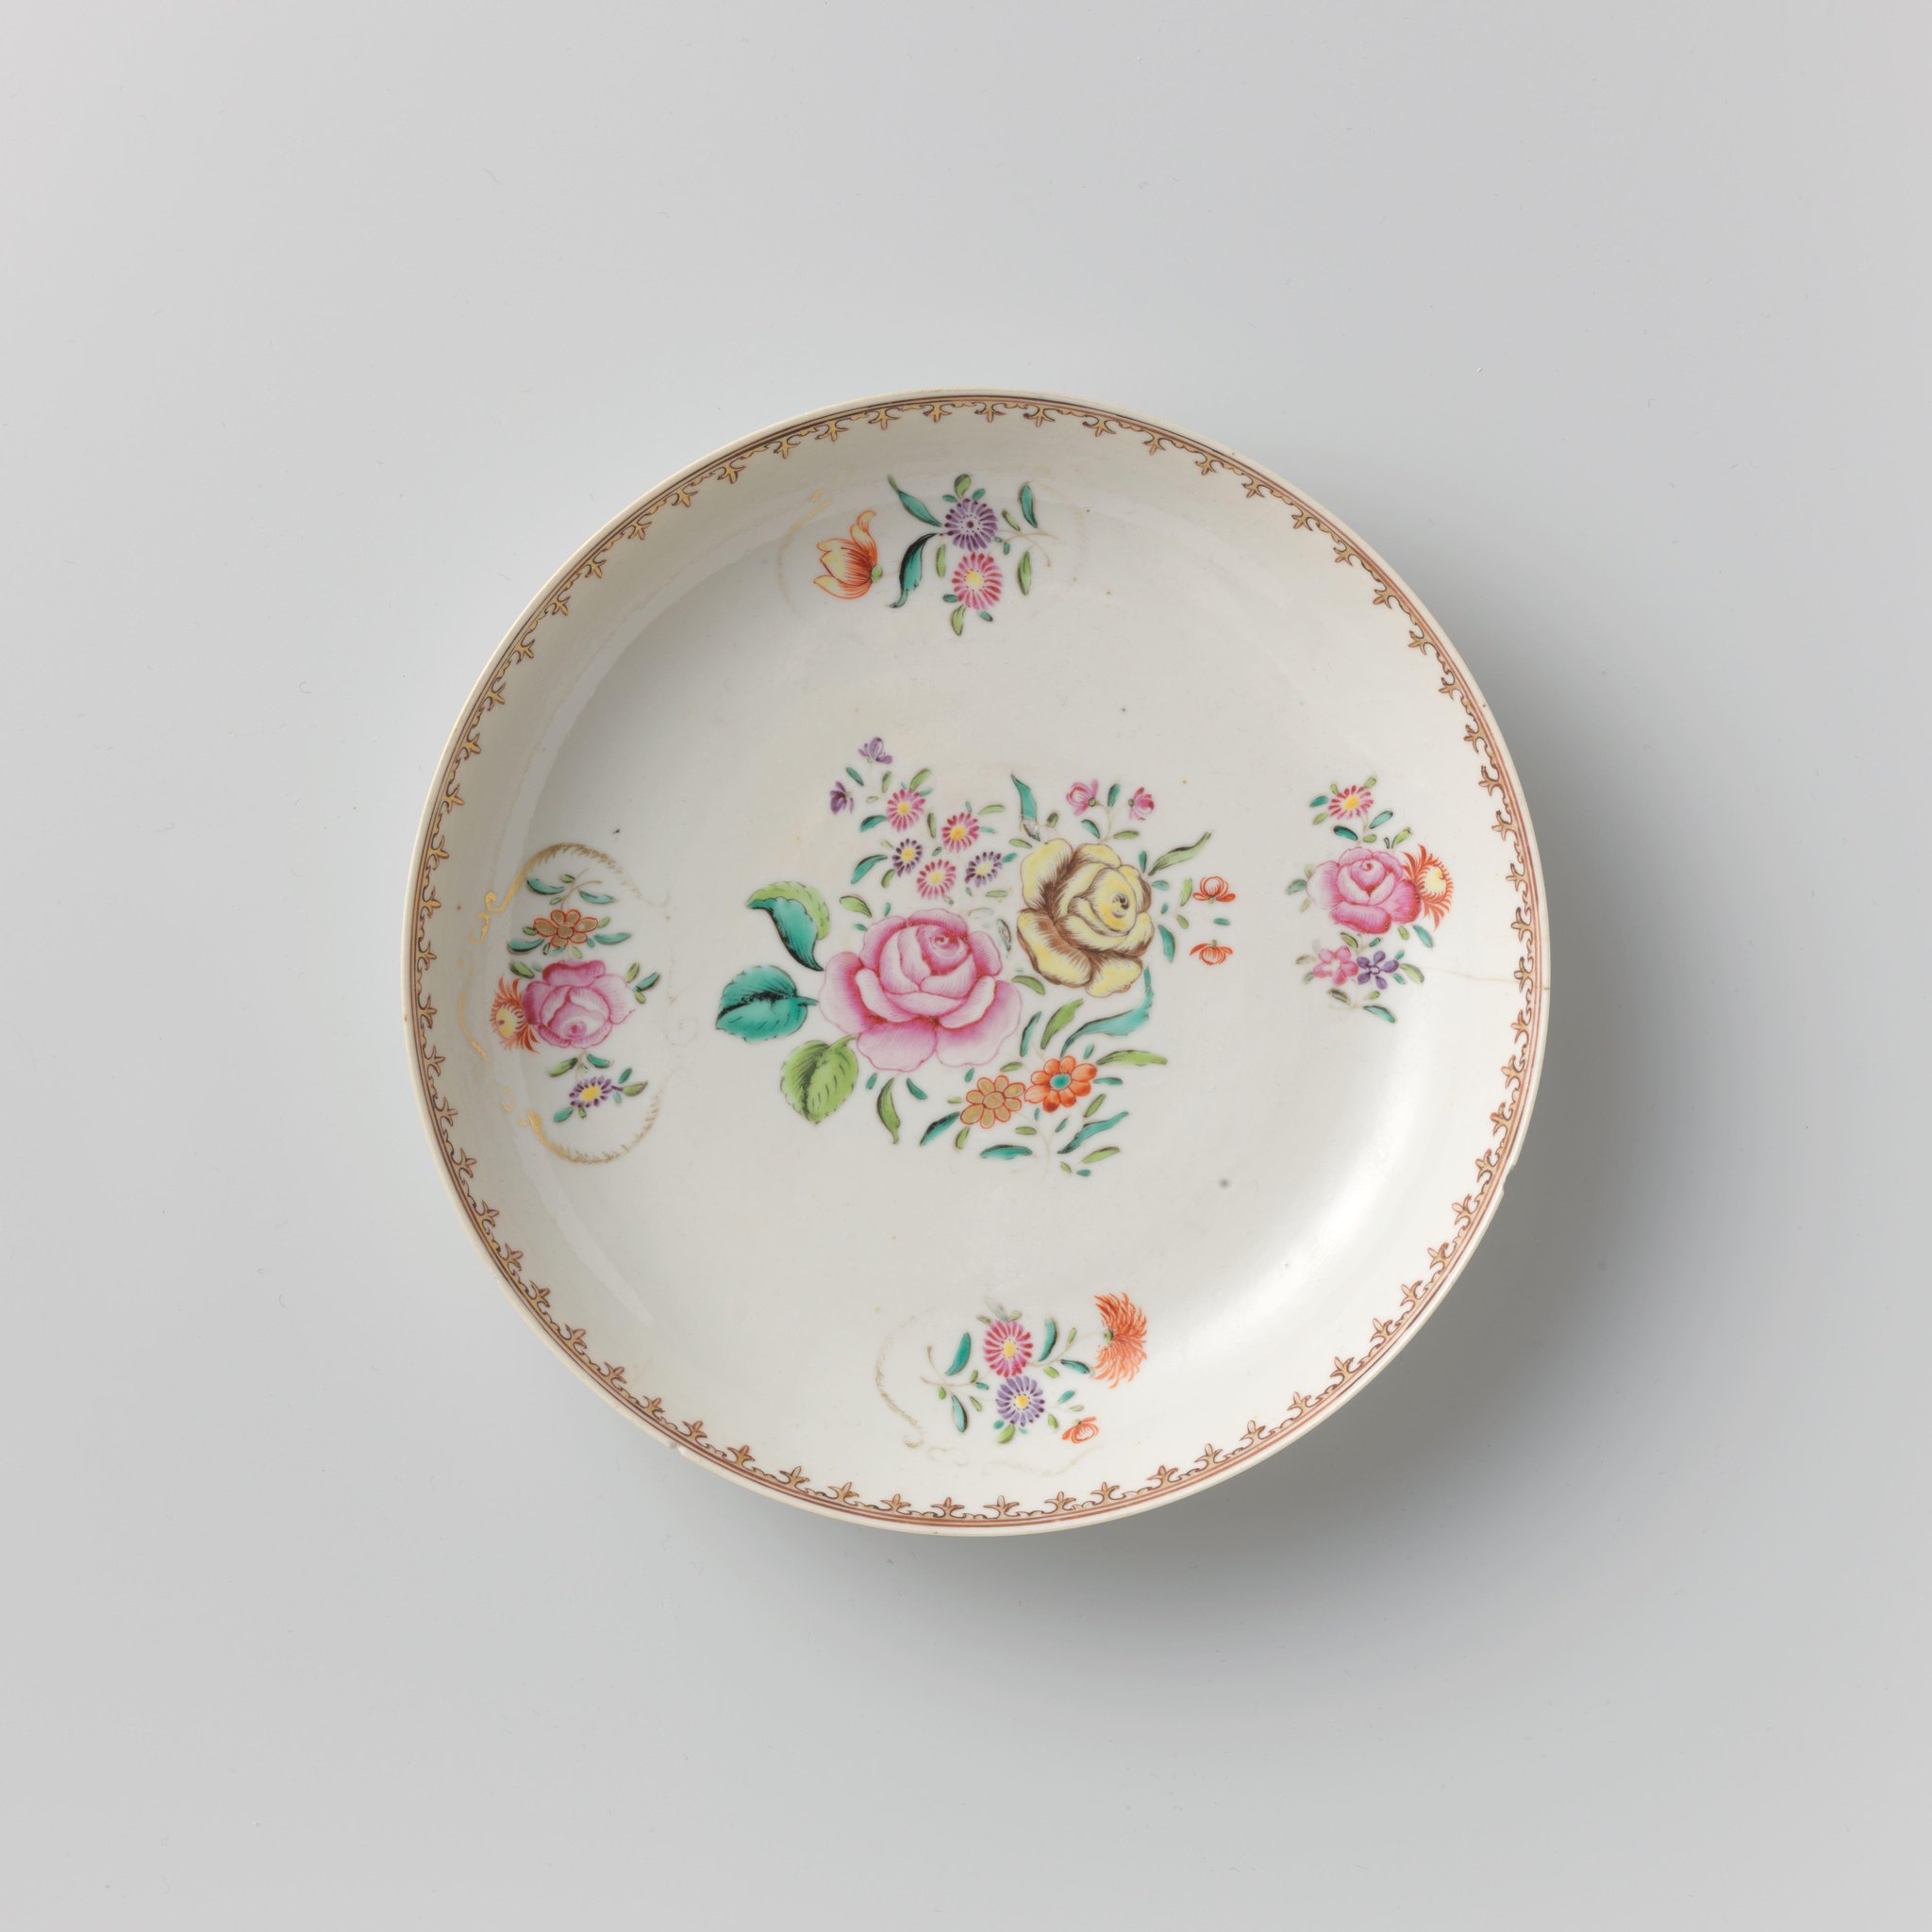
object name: dish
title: Saucer-dish with a group of flowers and flower sprays in panels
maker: Anonymous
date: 1750-1774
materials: glaze, gold, paint, porcelain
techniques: firing, gilding, turning, vitrification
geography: china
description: Schaal van porselein, beschilderd op het glazuur in blauw, rood, roze, groen, geel, paars, zwart en goud. Op de voorzijde een bloemgroep met daaromheen vier cartouches met bloemtakken; op de binnenrand een 'spearhead-border'. Enkele barsten en chips in de rand. Famille rose.